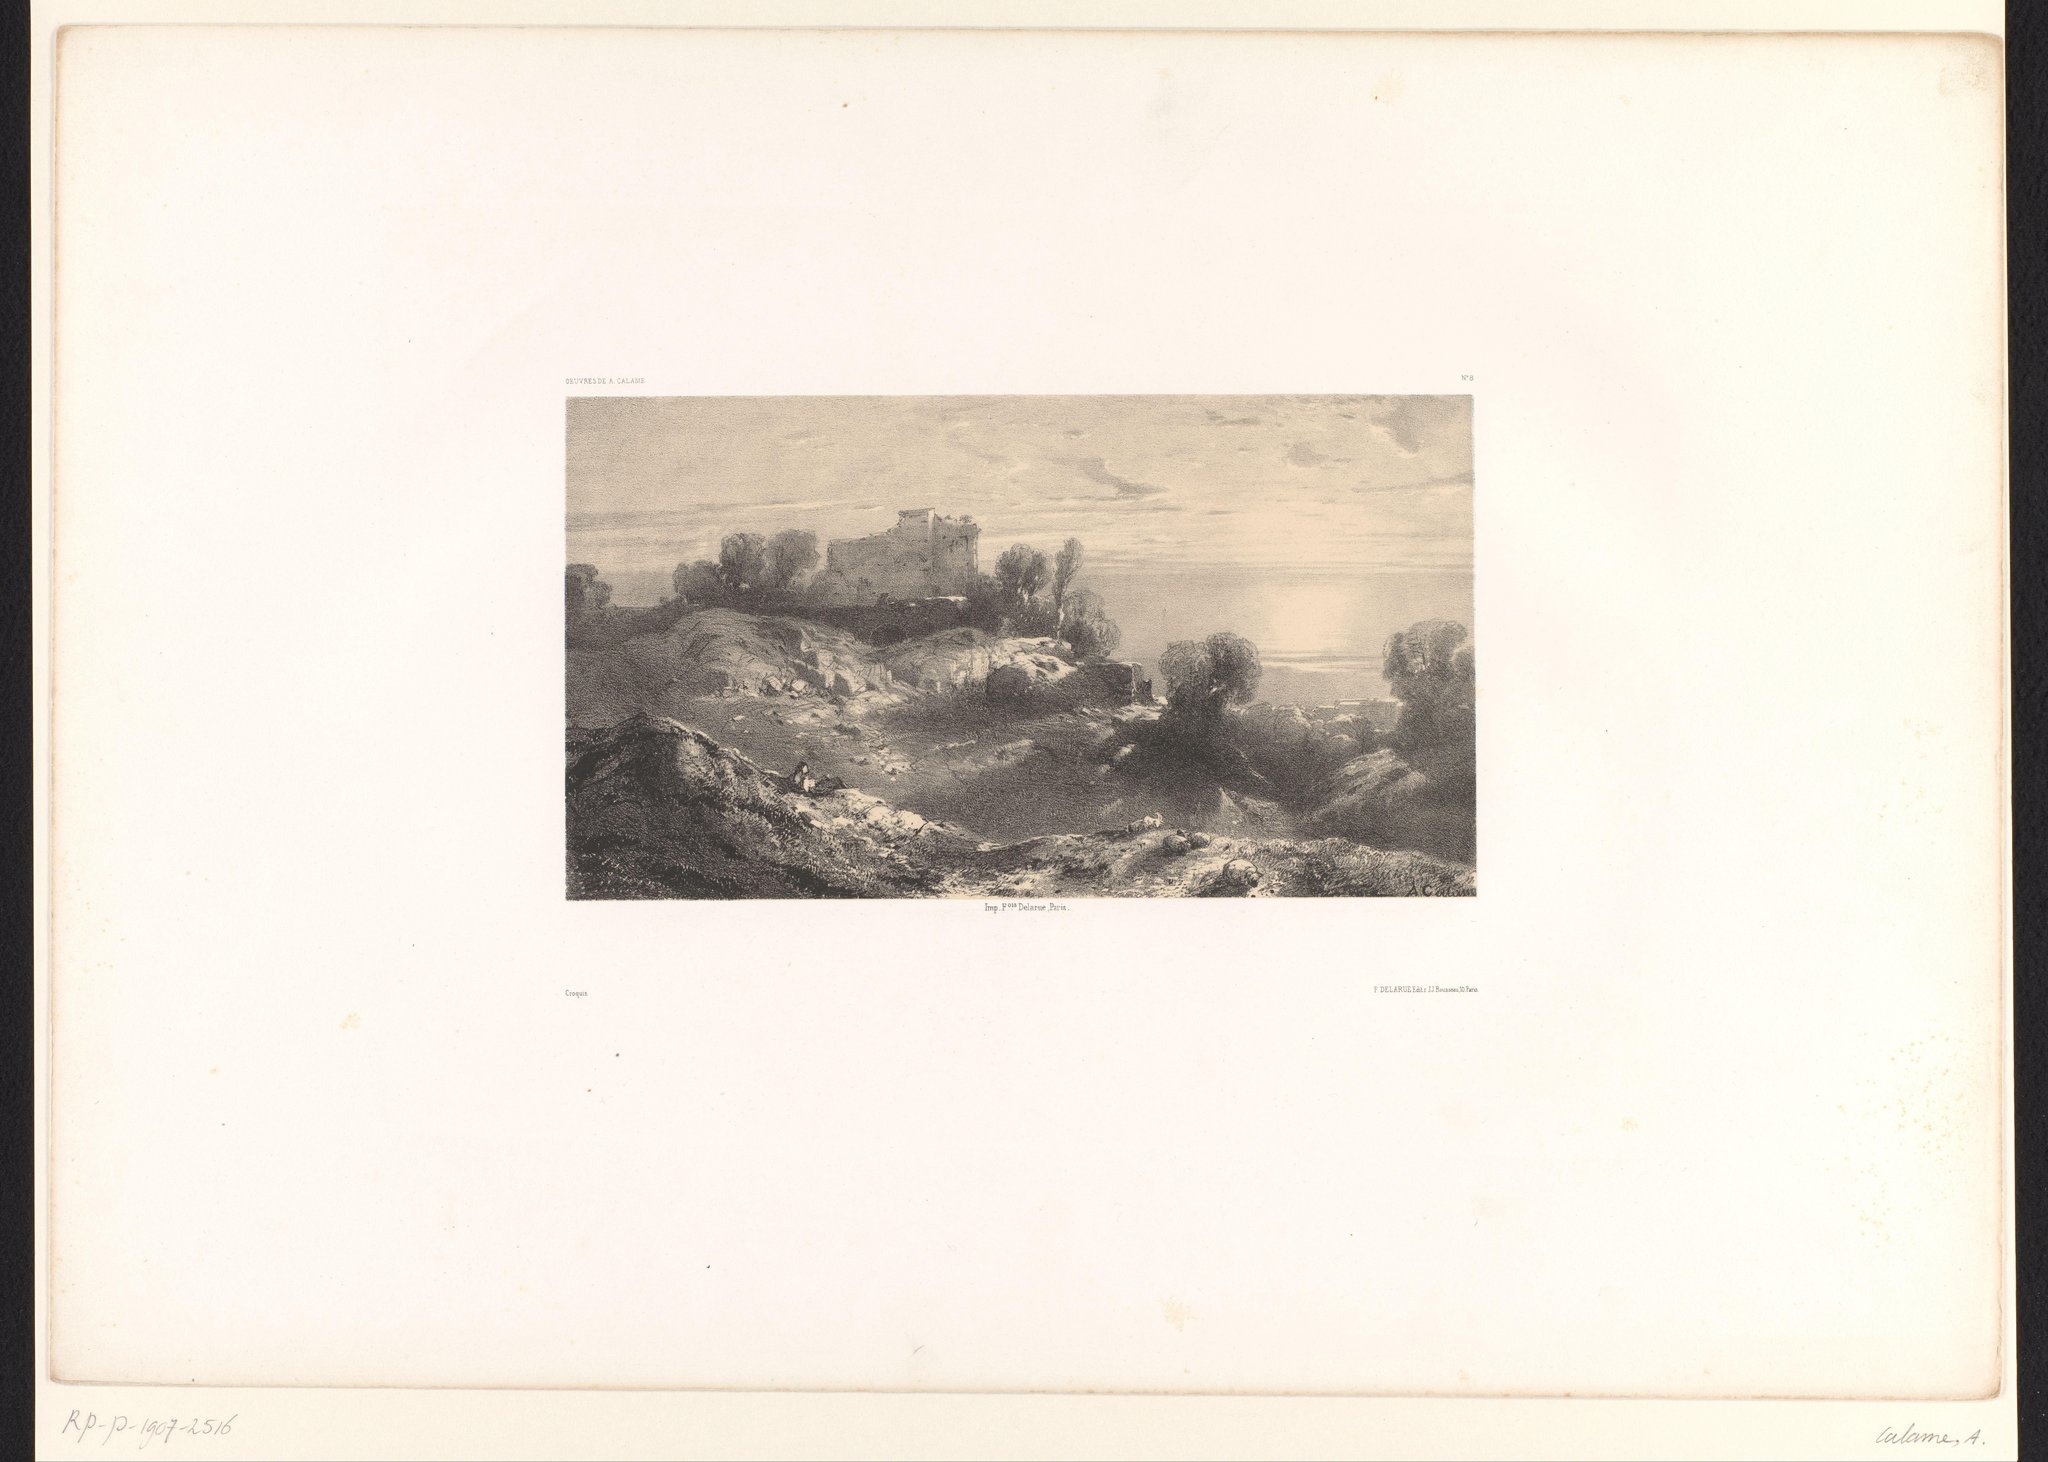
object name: print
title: Landschap met ruïne op de rotsen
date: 1852-1855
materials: paper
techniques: lithograph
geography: paris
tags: landscape with ruins, rocks (+ landscape with figures, staffage), ruin of a dwelling, house, castle, etc.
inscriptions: collector's mark: Lugt 2228a